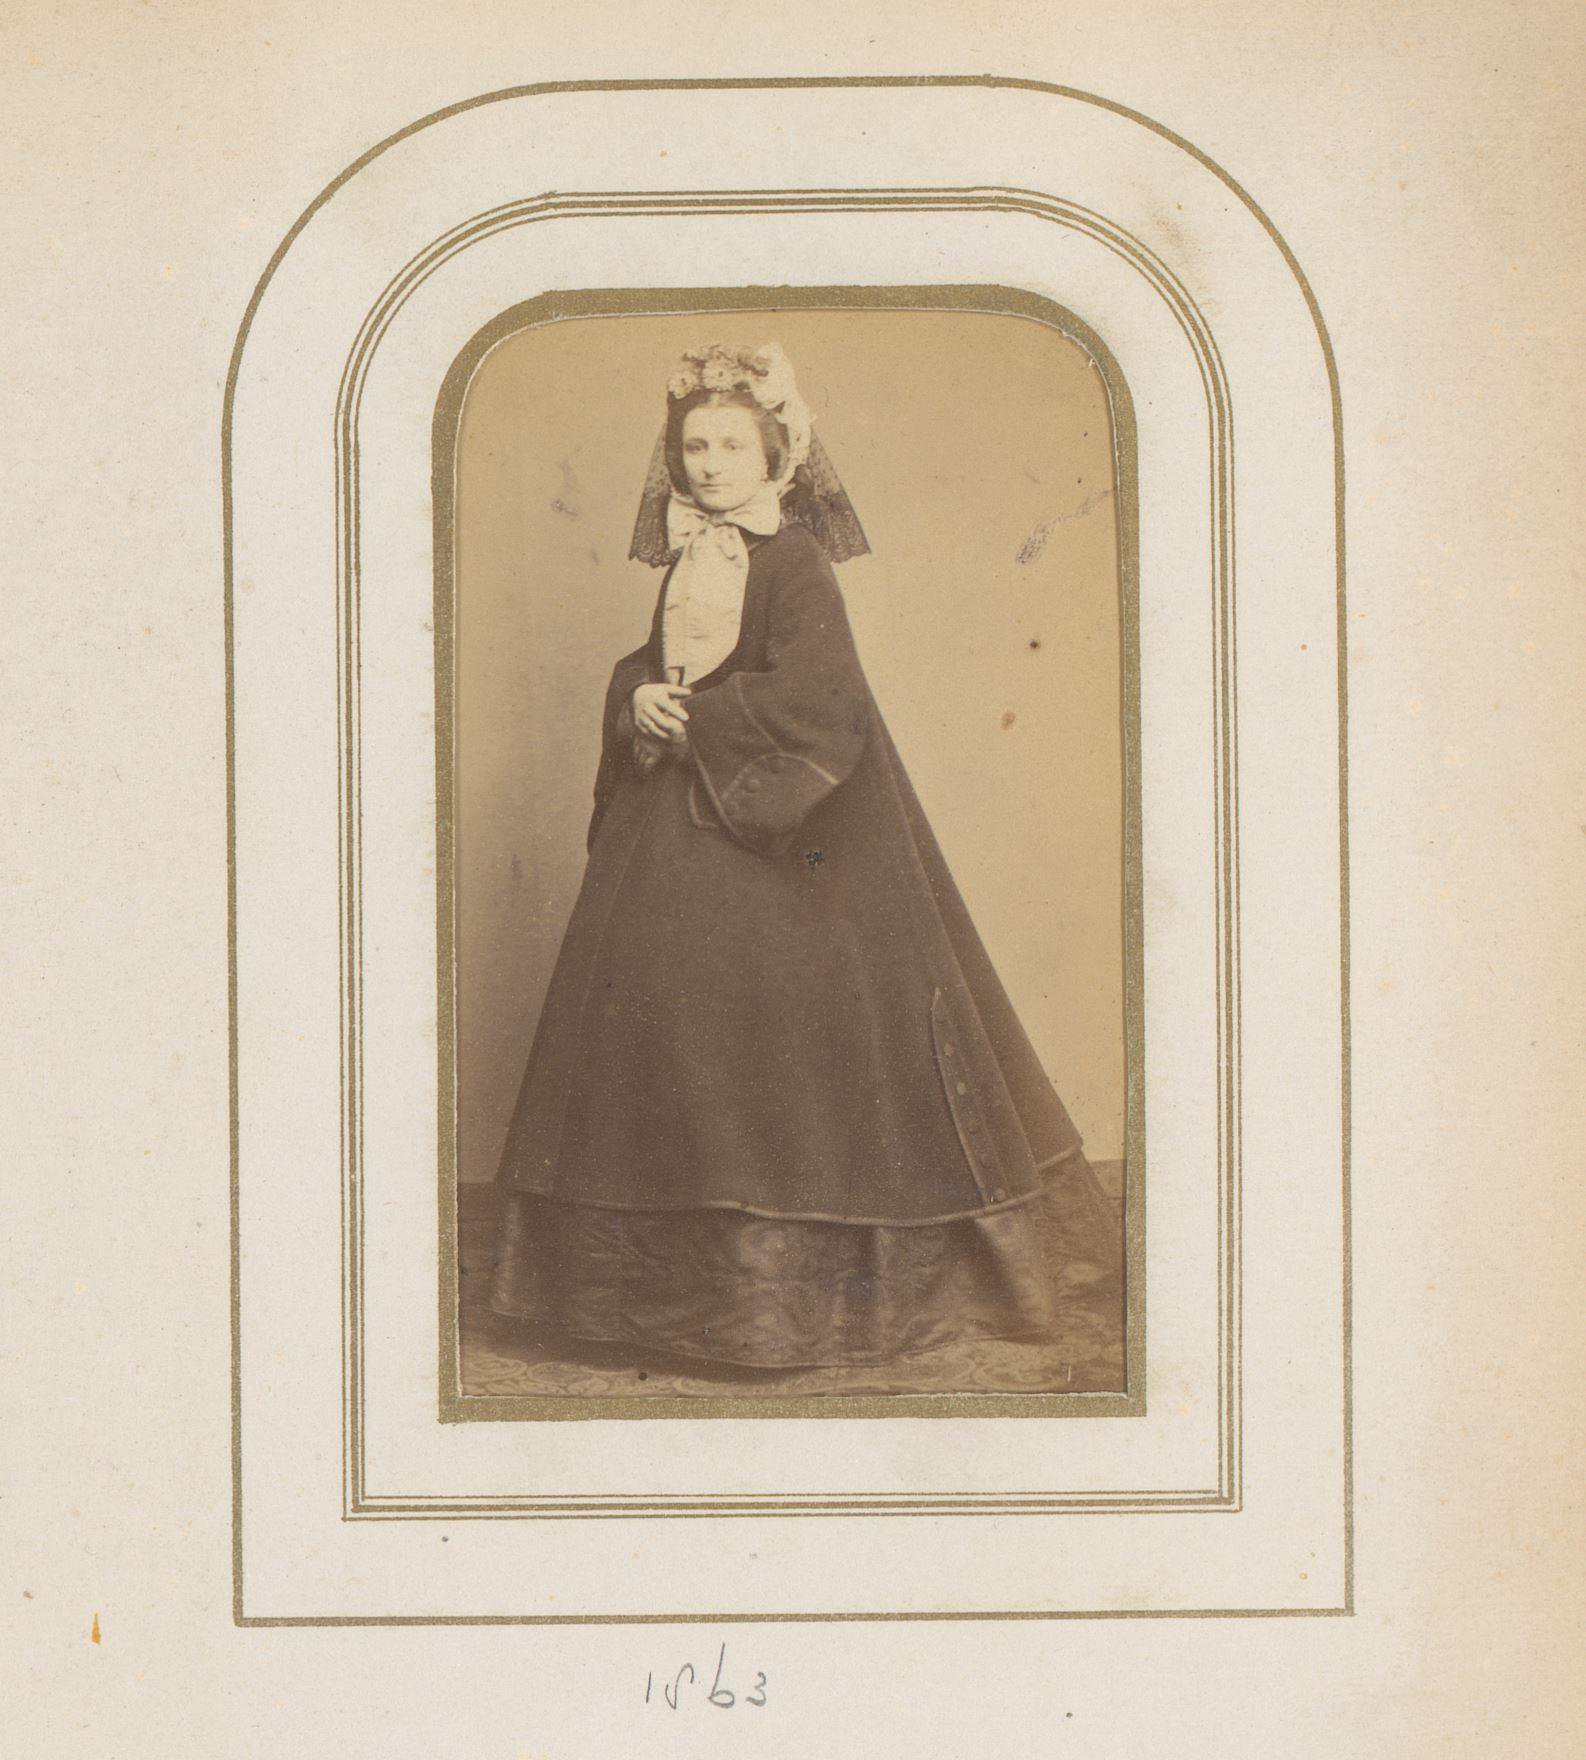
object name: photograph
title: Portret van een vrouw met muts en strik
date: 1863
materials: cardboard, photographic support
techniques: albumen print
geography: brussels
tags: historical persons - bb - woman, head-gear: hat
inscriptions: inscription: ‘Atelier de Photographie/ Ghémar Frères/ Photographes du Roi/ 27, rue de l'Ecuyer/ entrée par la porte cochère/ Bruxelles’, annotation: ‘a mon excellent ami/ Alex Lemoine/ [Laddy]/ 17 1/63’